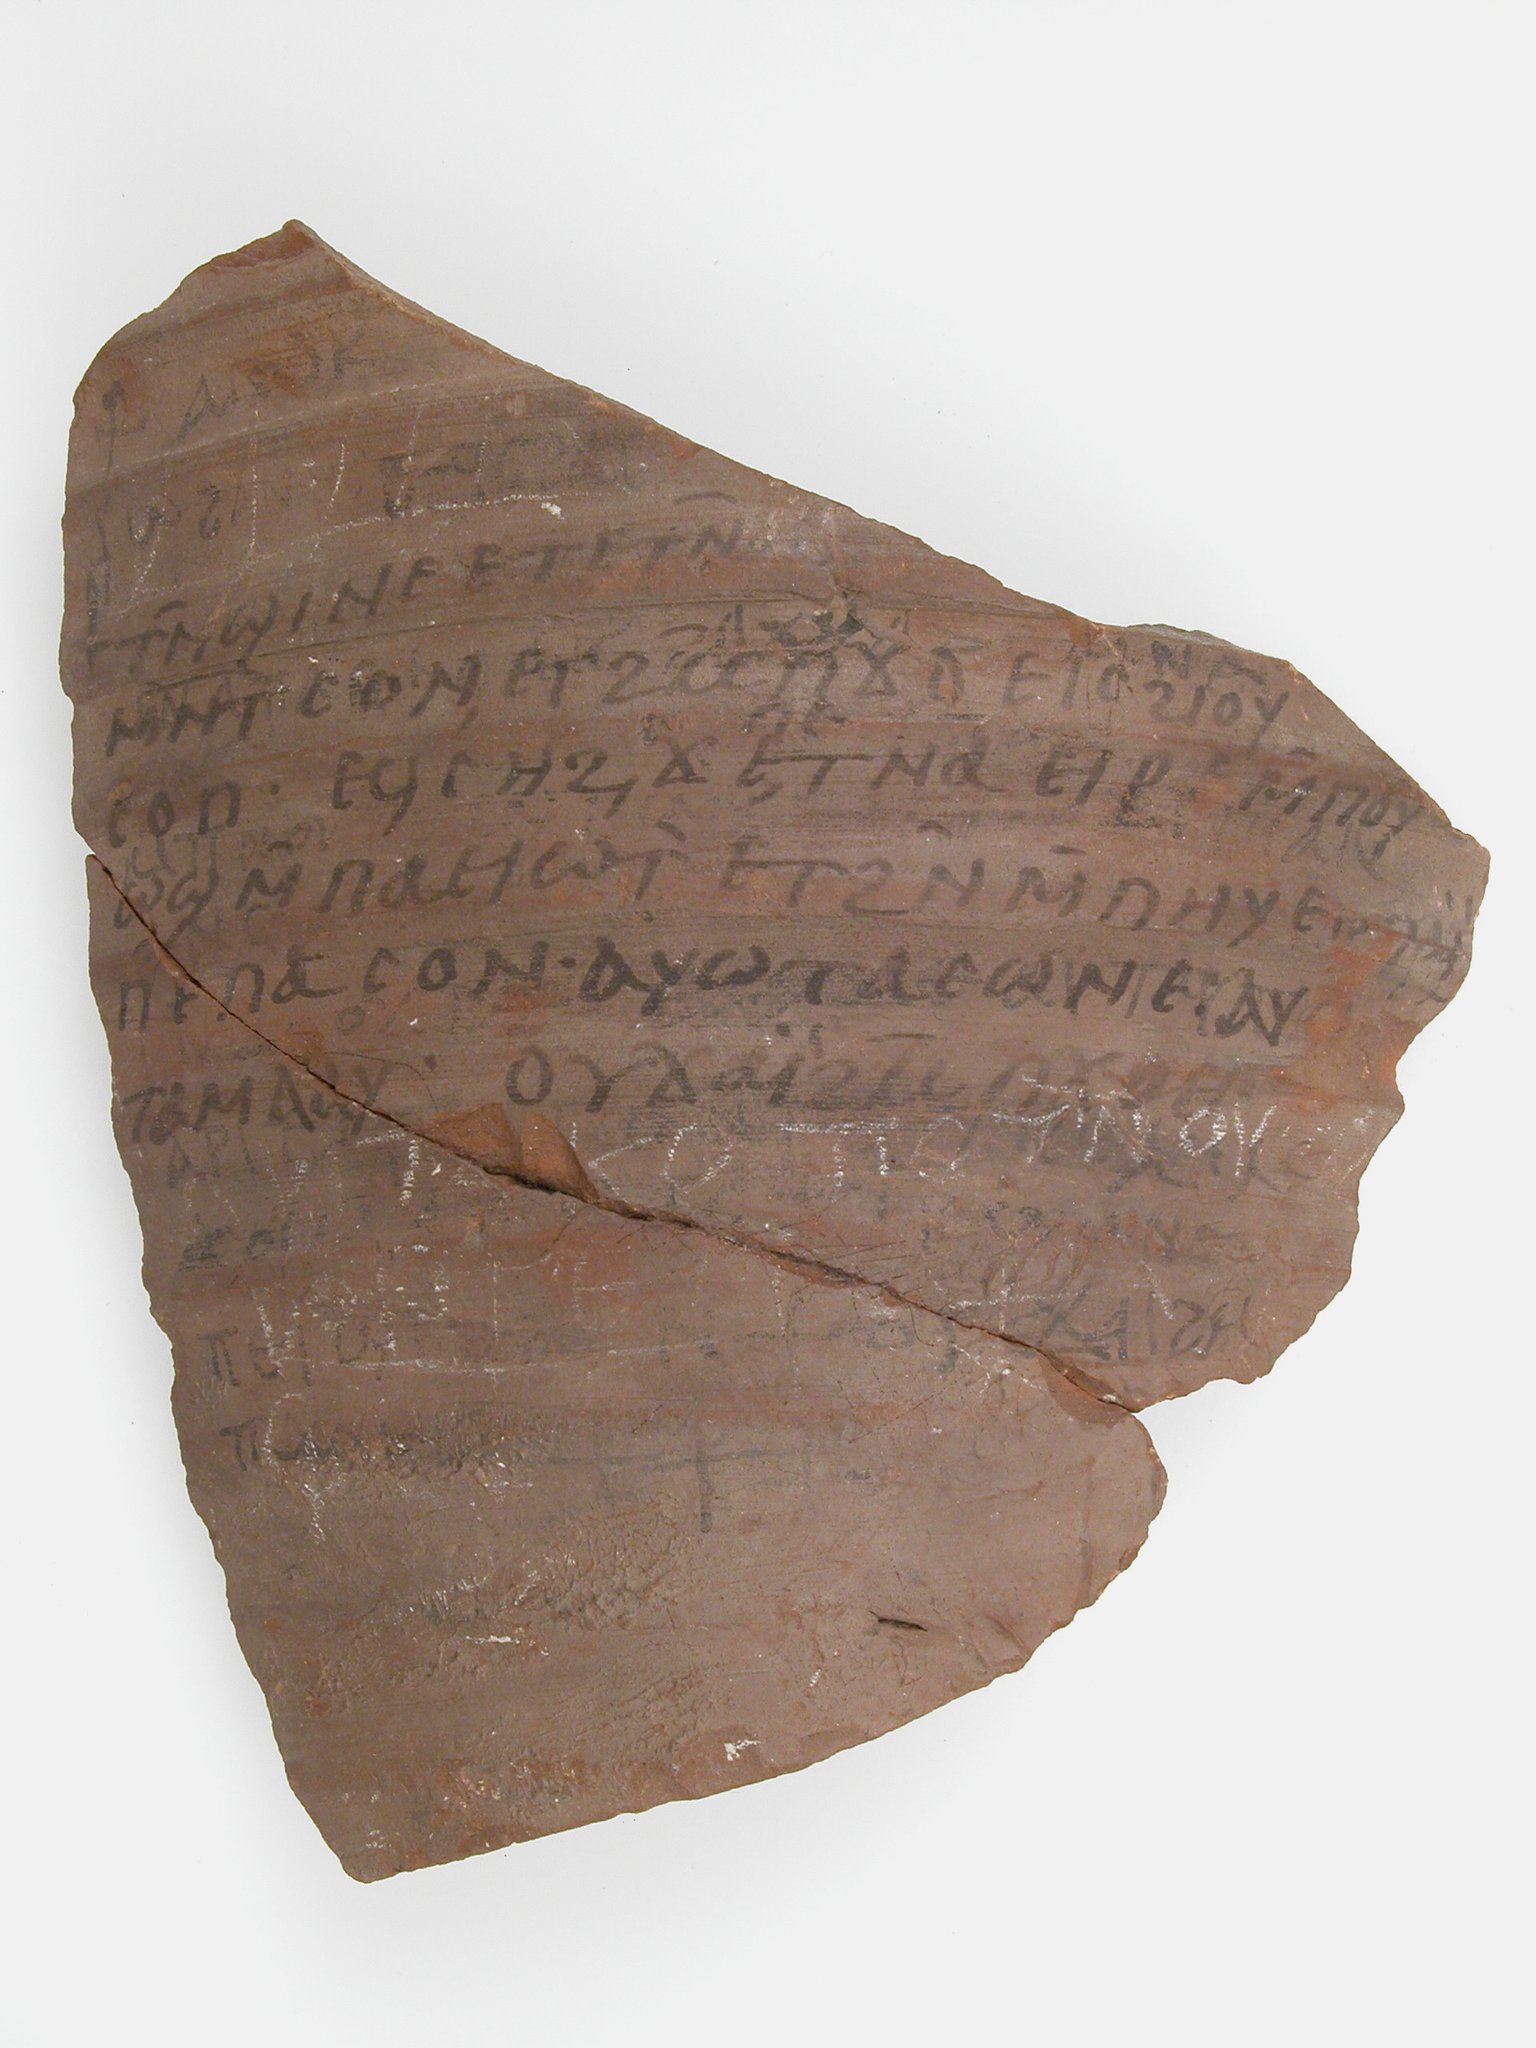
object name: ostrakon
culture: coptic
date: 601-700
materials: ink, pottery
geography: egypt